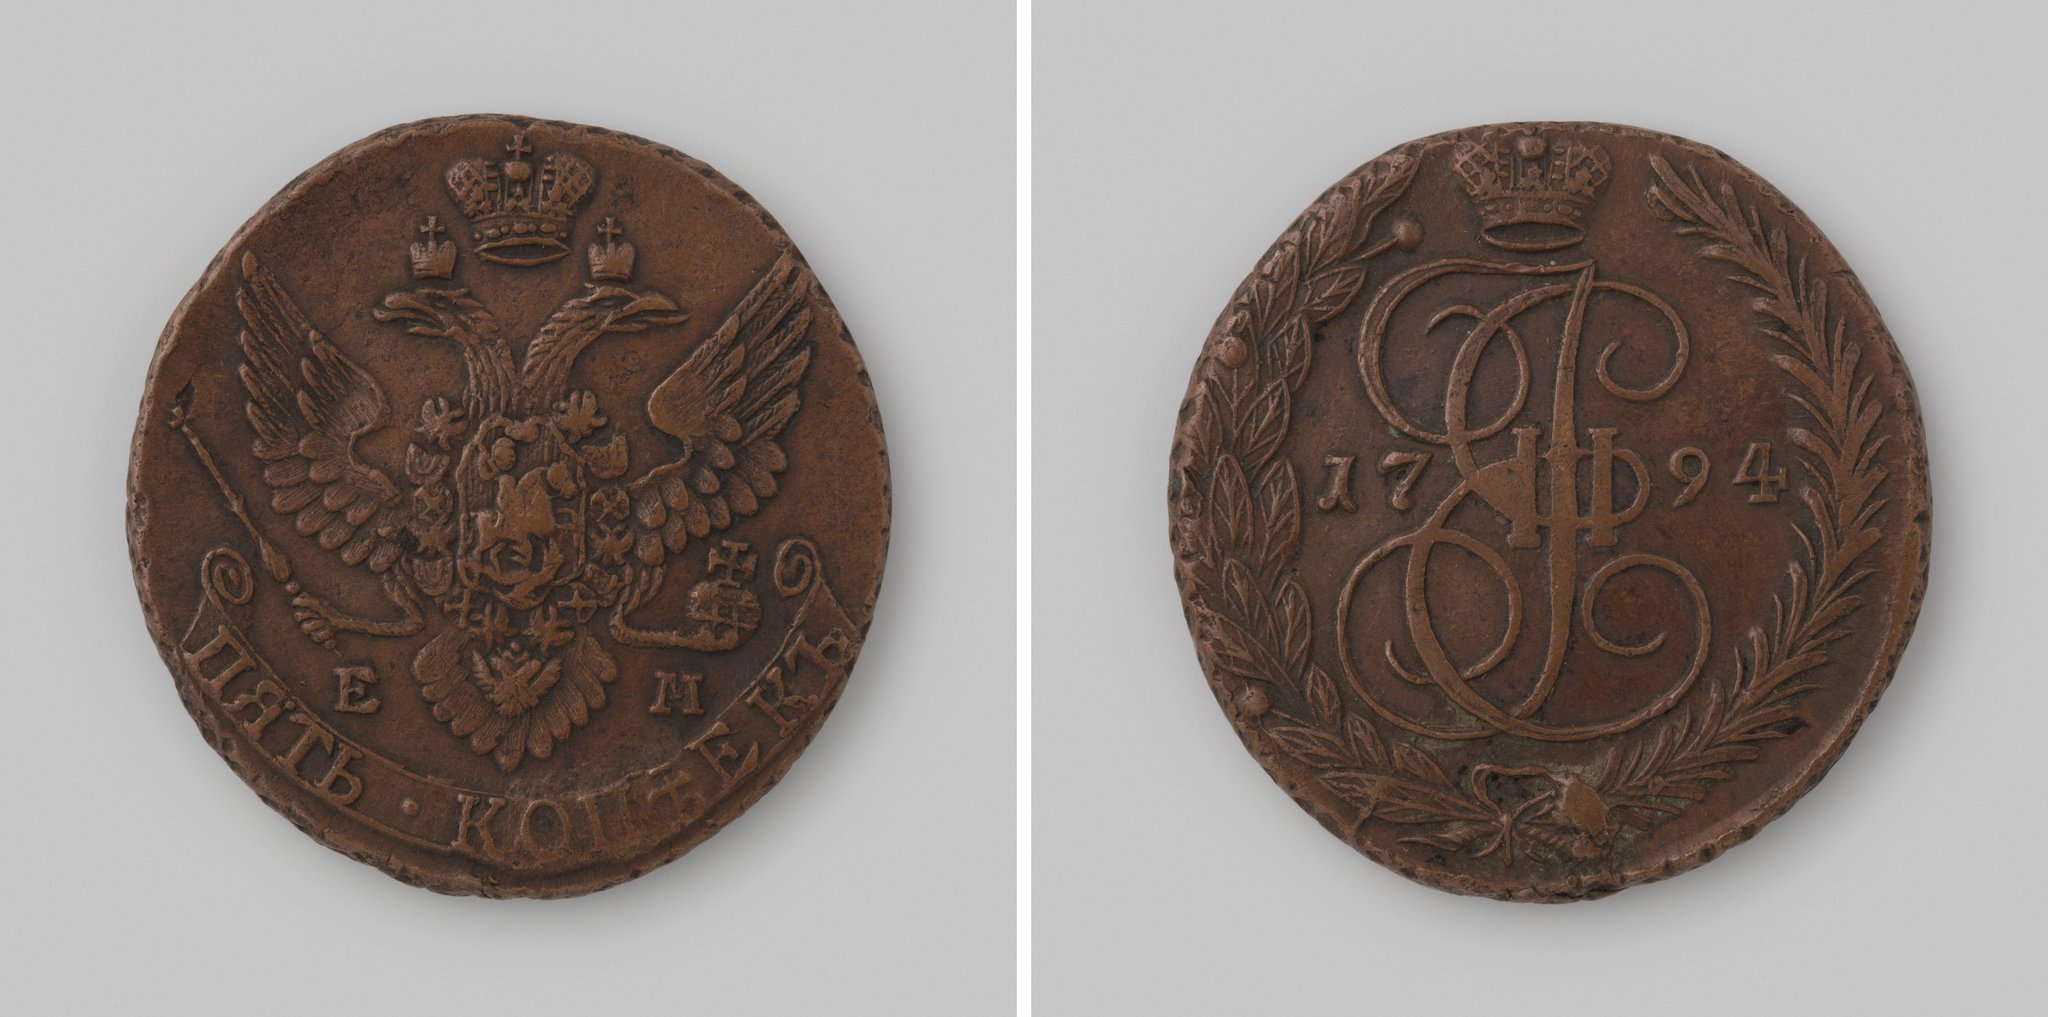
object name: coin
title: 5 kopeken uit Rusland van tsarina Catherina II, 1794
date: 1794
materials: copper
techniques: striking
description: Koperen munt. Voorzijde: dubbelkoppige gekroonde adelaar met gespreide vleugels, met op zijn borst door ridderorde omhangen wapenschild en met in zijn poten scepter en bol met daarop kruis. Boven de adelaar een kroon. Links en rechts onder de staart de letters E M [=Ekaterinenburg]. Onderaan op een banderol waarde-aanduiding. Keerzijde: binnen twee samengebonden takken tussen het jaartal gekroond monogram van de czarina. Kabelrand.